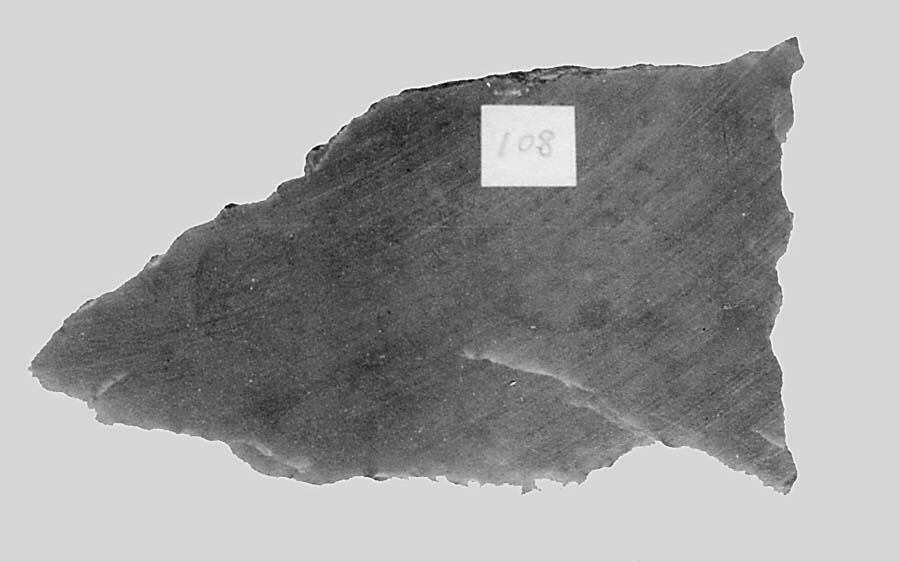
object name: fragment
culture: russian, siberia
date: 1902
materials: jade